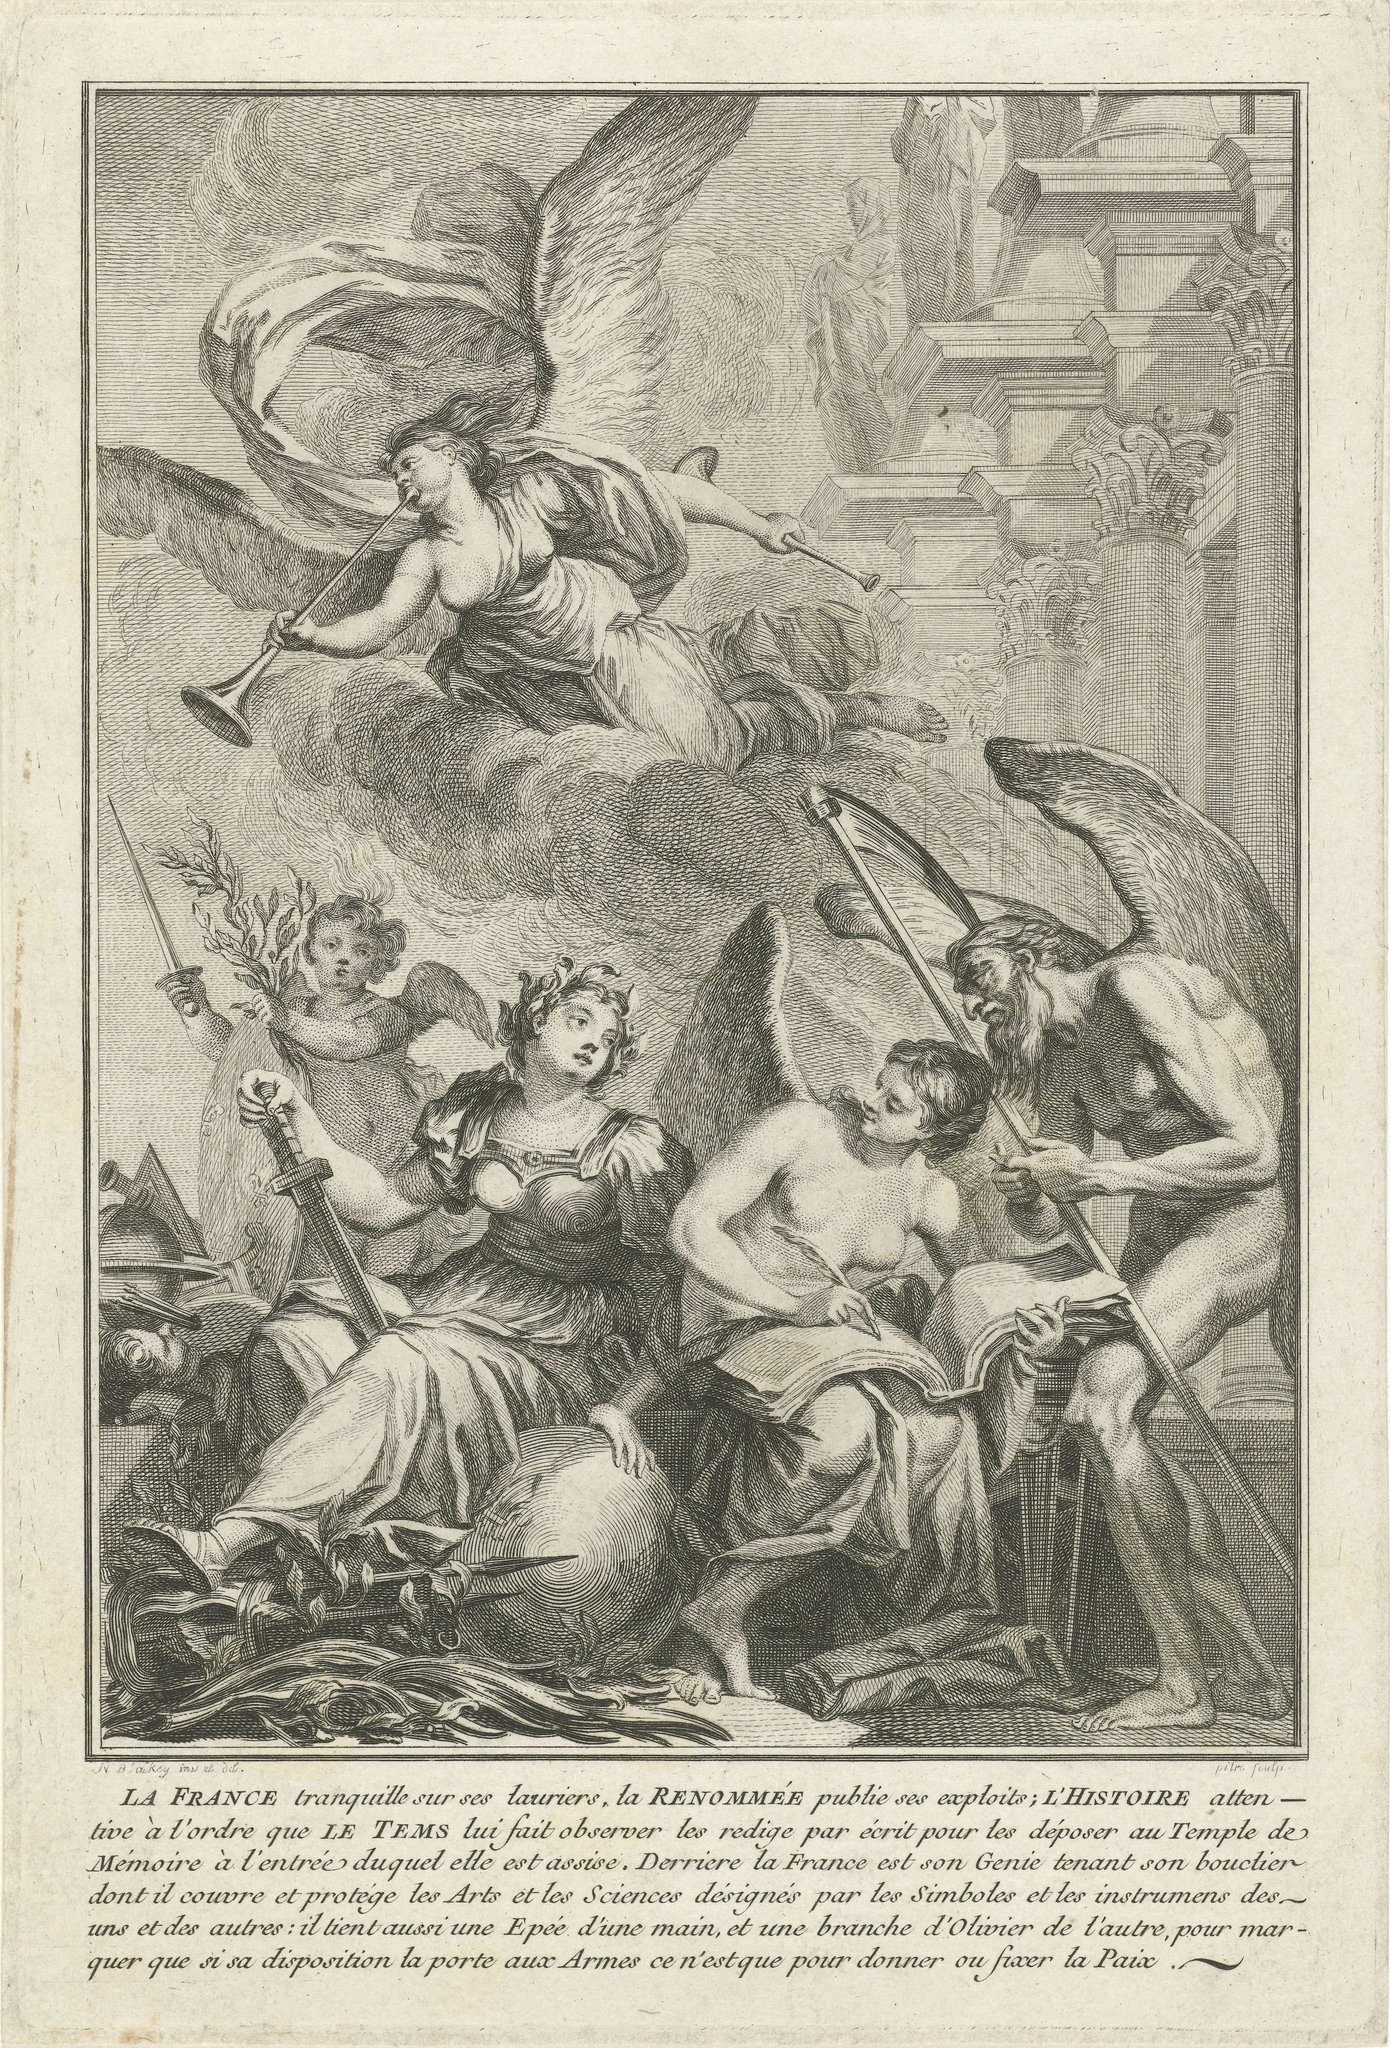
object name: print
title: Allegorische voorstelling met Frankrijk, Geschiedschrijving en Vader Tijd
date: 1739-1789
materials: paper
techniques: engraving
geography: antwerp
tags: 'historia'; 'historia' (ripa), fame; 'fama', 'fama buona', 'fama chiara' (ripa), father time, man with wings and scythe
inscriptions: collector's mark: Lugt 2228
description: Een zittende allegorische vrouwenfiguur, voorstellende Frankrijk, met achter haar een putto wordt vergezeld door de gepersonifieerde Geschiedschrijving en Vader Tijd. Boven hen Faam blazend op een bazuin.